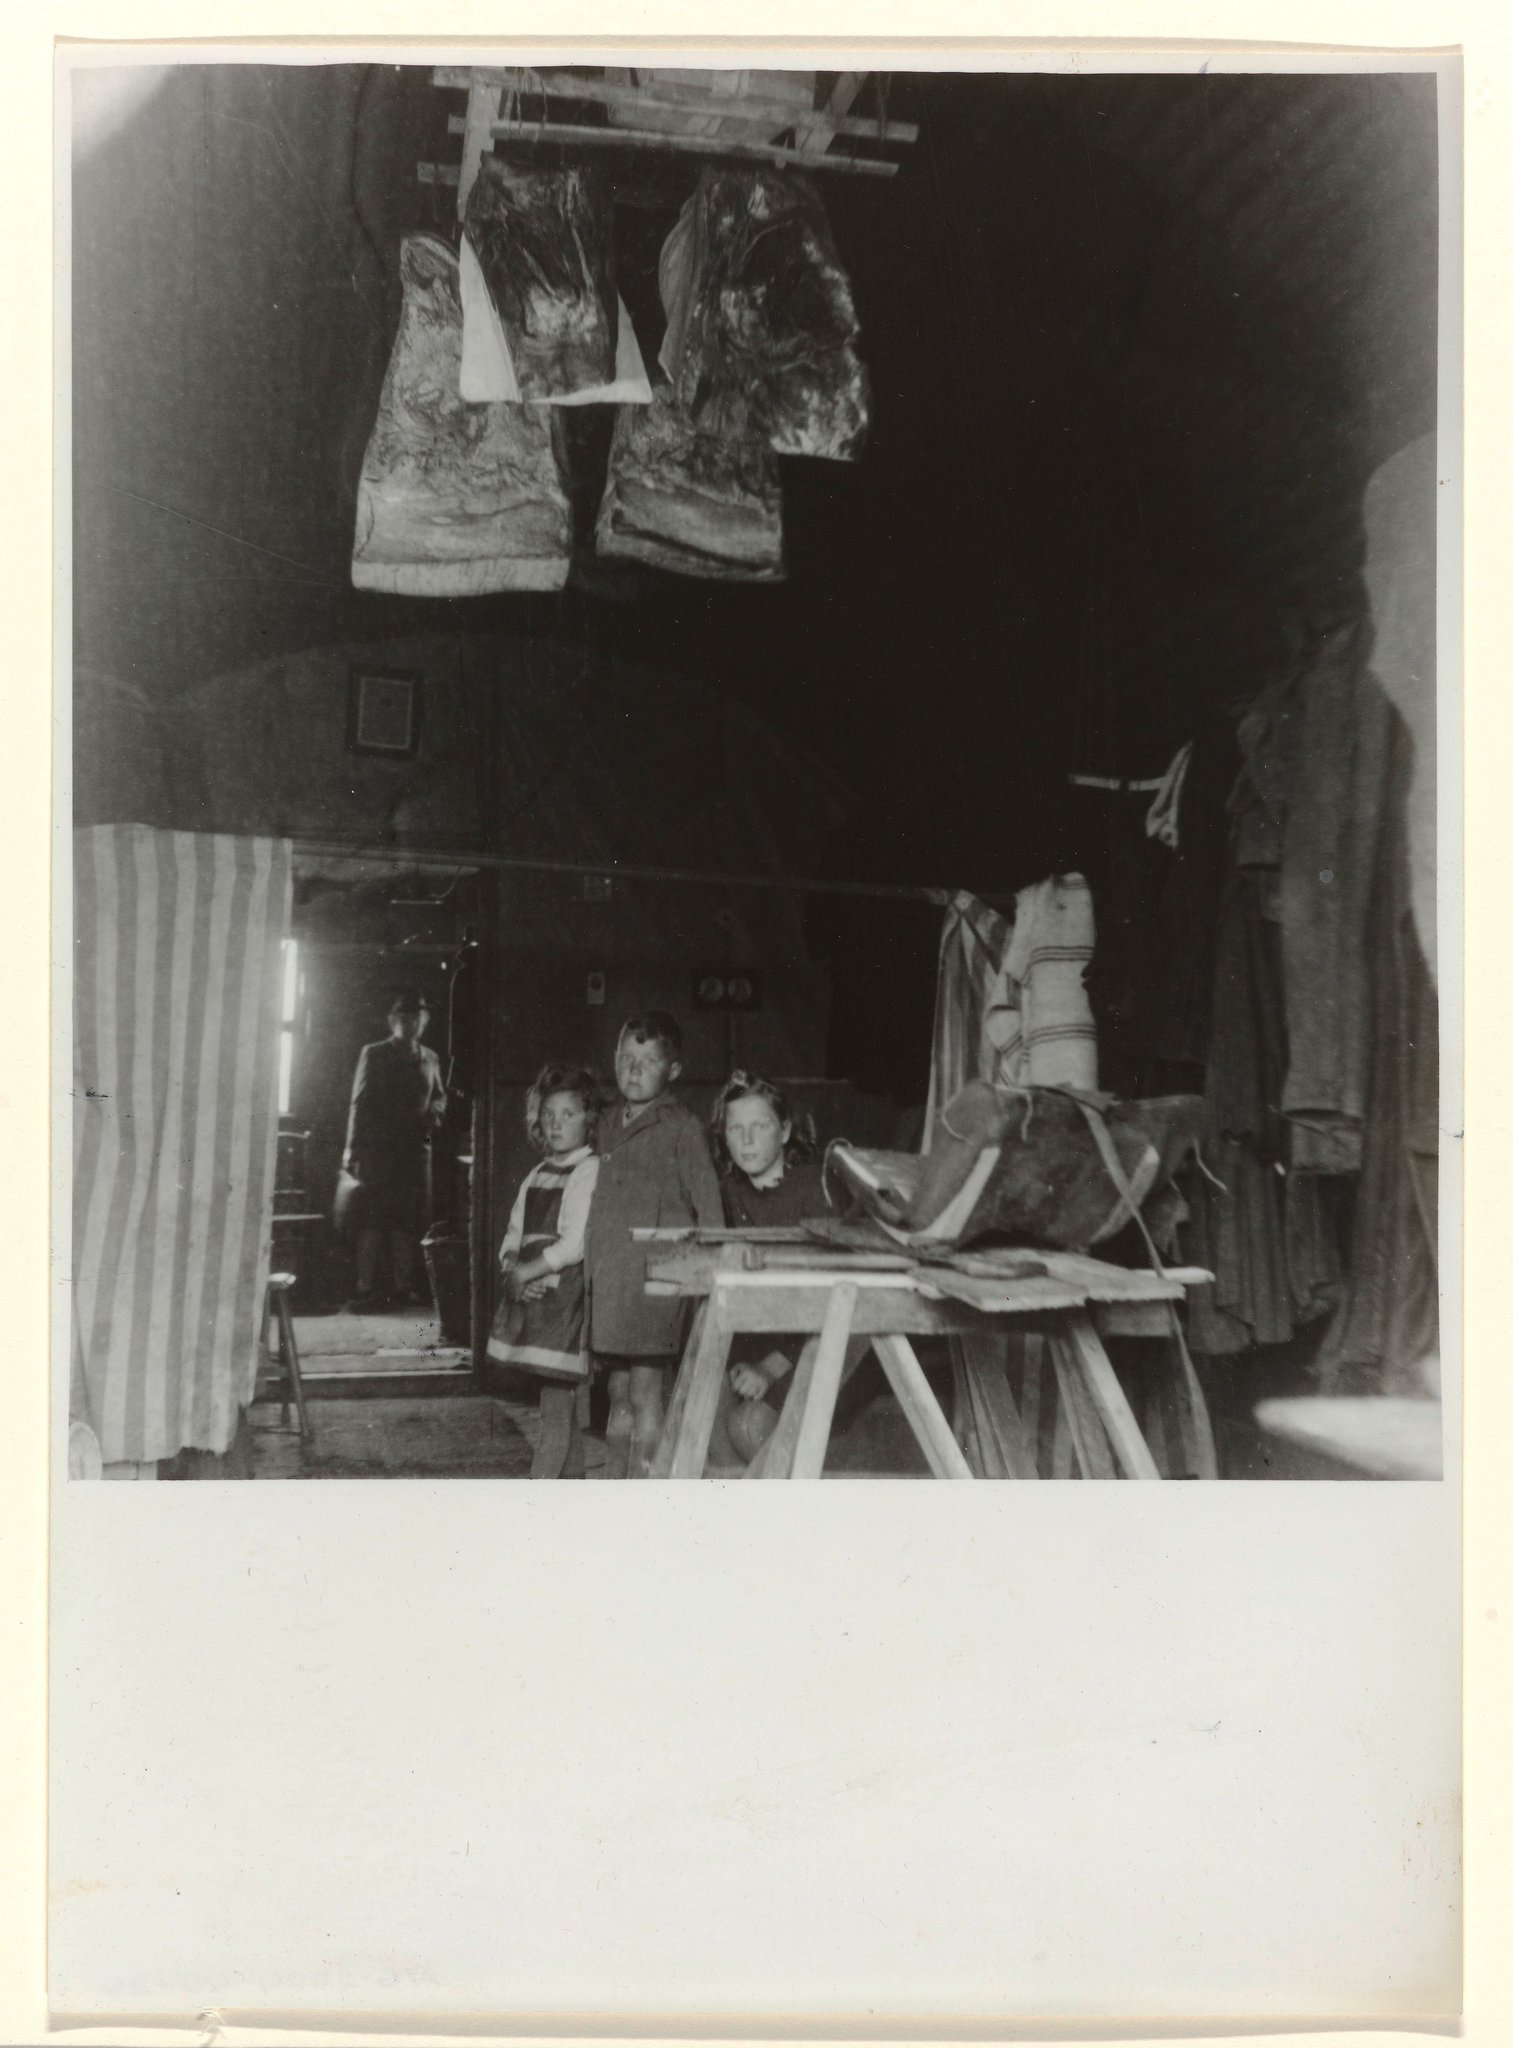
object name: documentary photograph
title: Drie kinderen in een geïmproviseerde woning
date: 1945-1947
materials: photographic support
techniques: photography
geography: netherlands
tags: netherlands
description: In een interieur staan drie kinderen bij een tafel van planken en schragen. Achter een gestreept gordijn links is een bed zichtbaar en een vrouw.